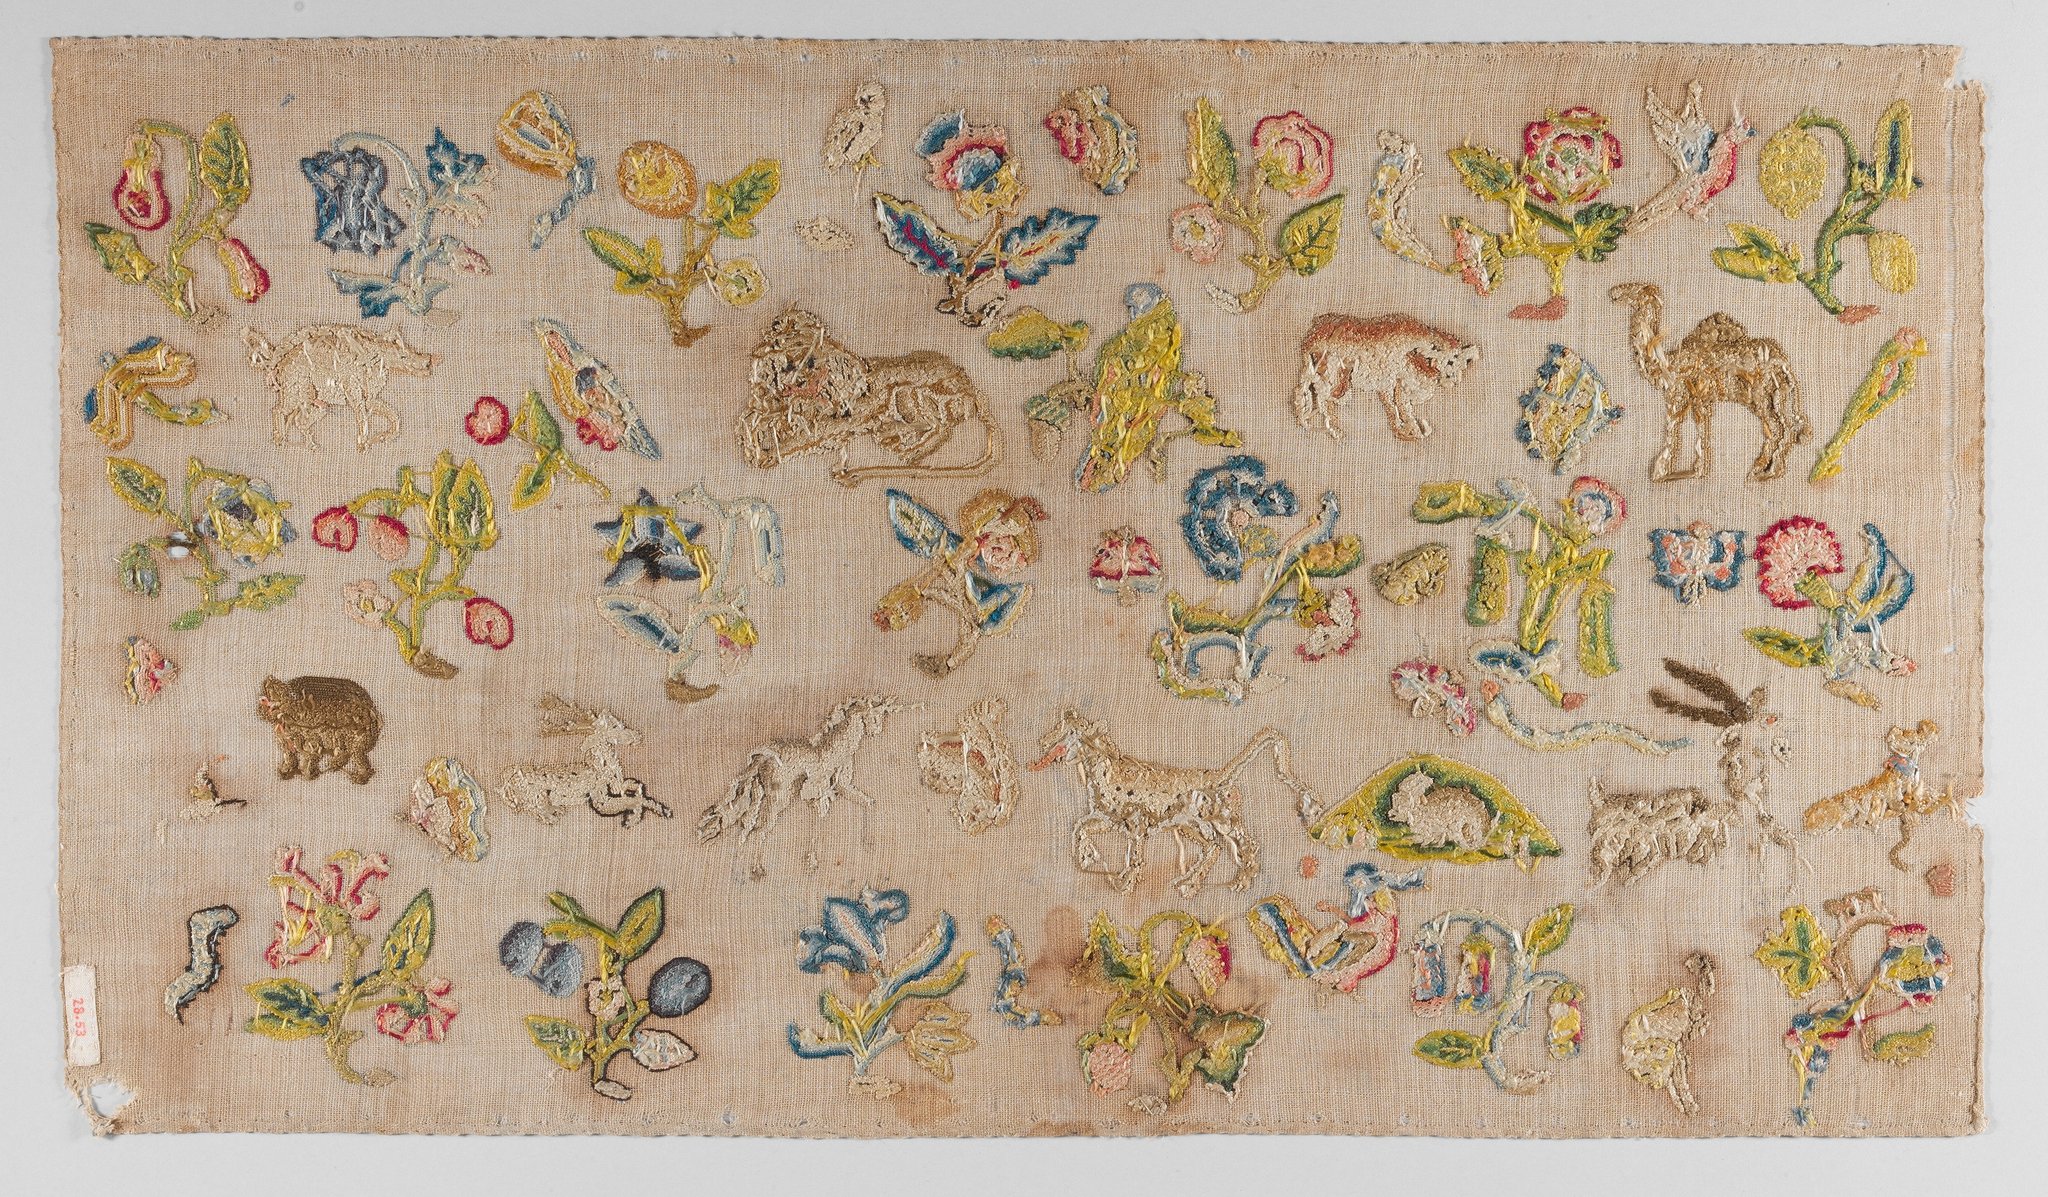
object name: panel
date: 1601-1650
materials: linen, silk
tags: birds,unicorns,camels,flowers